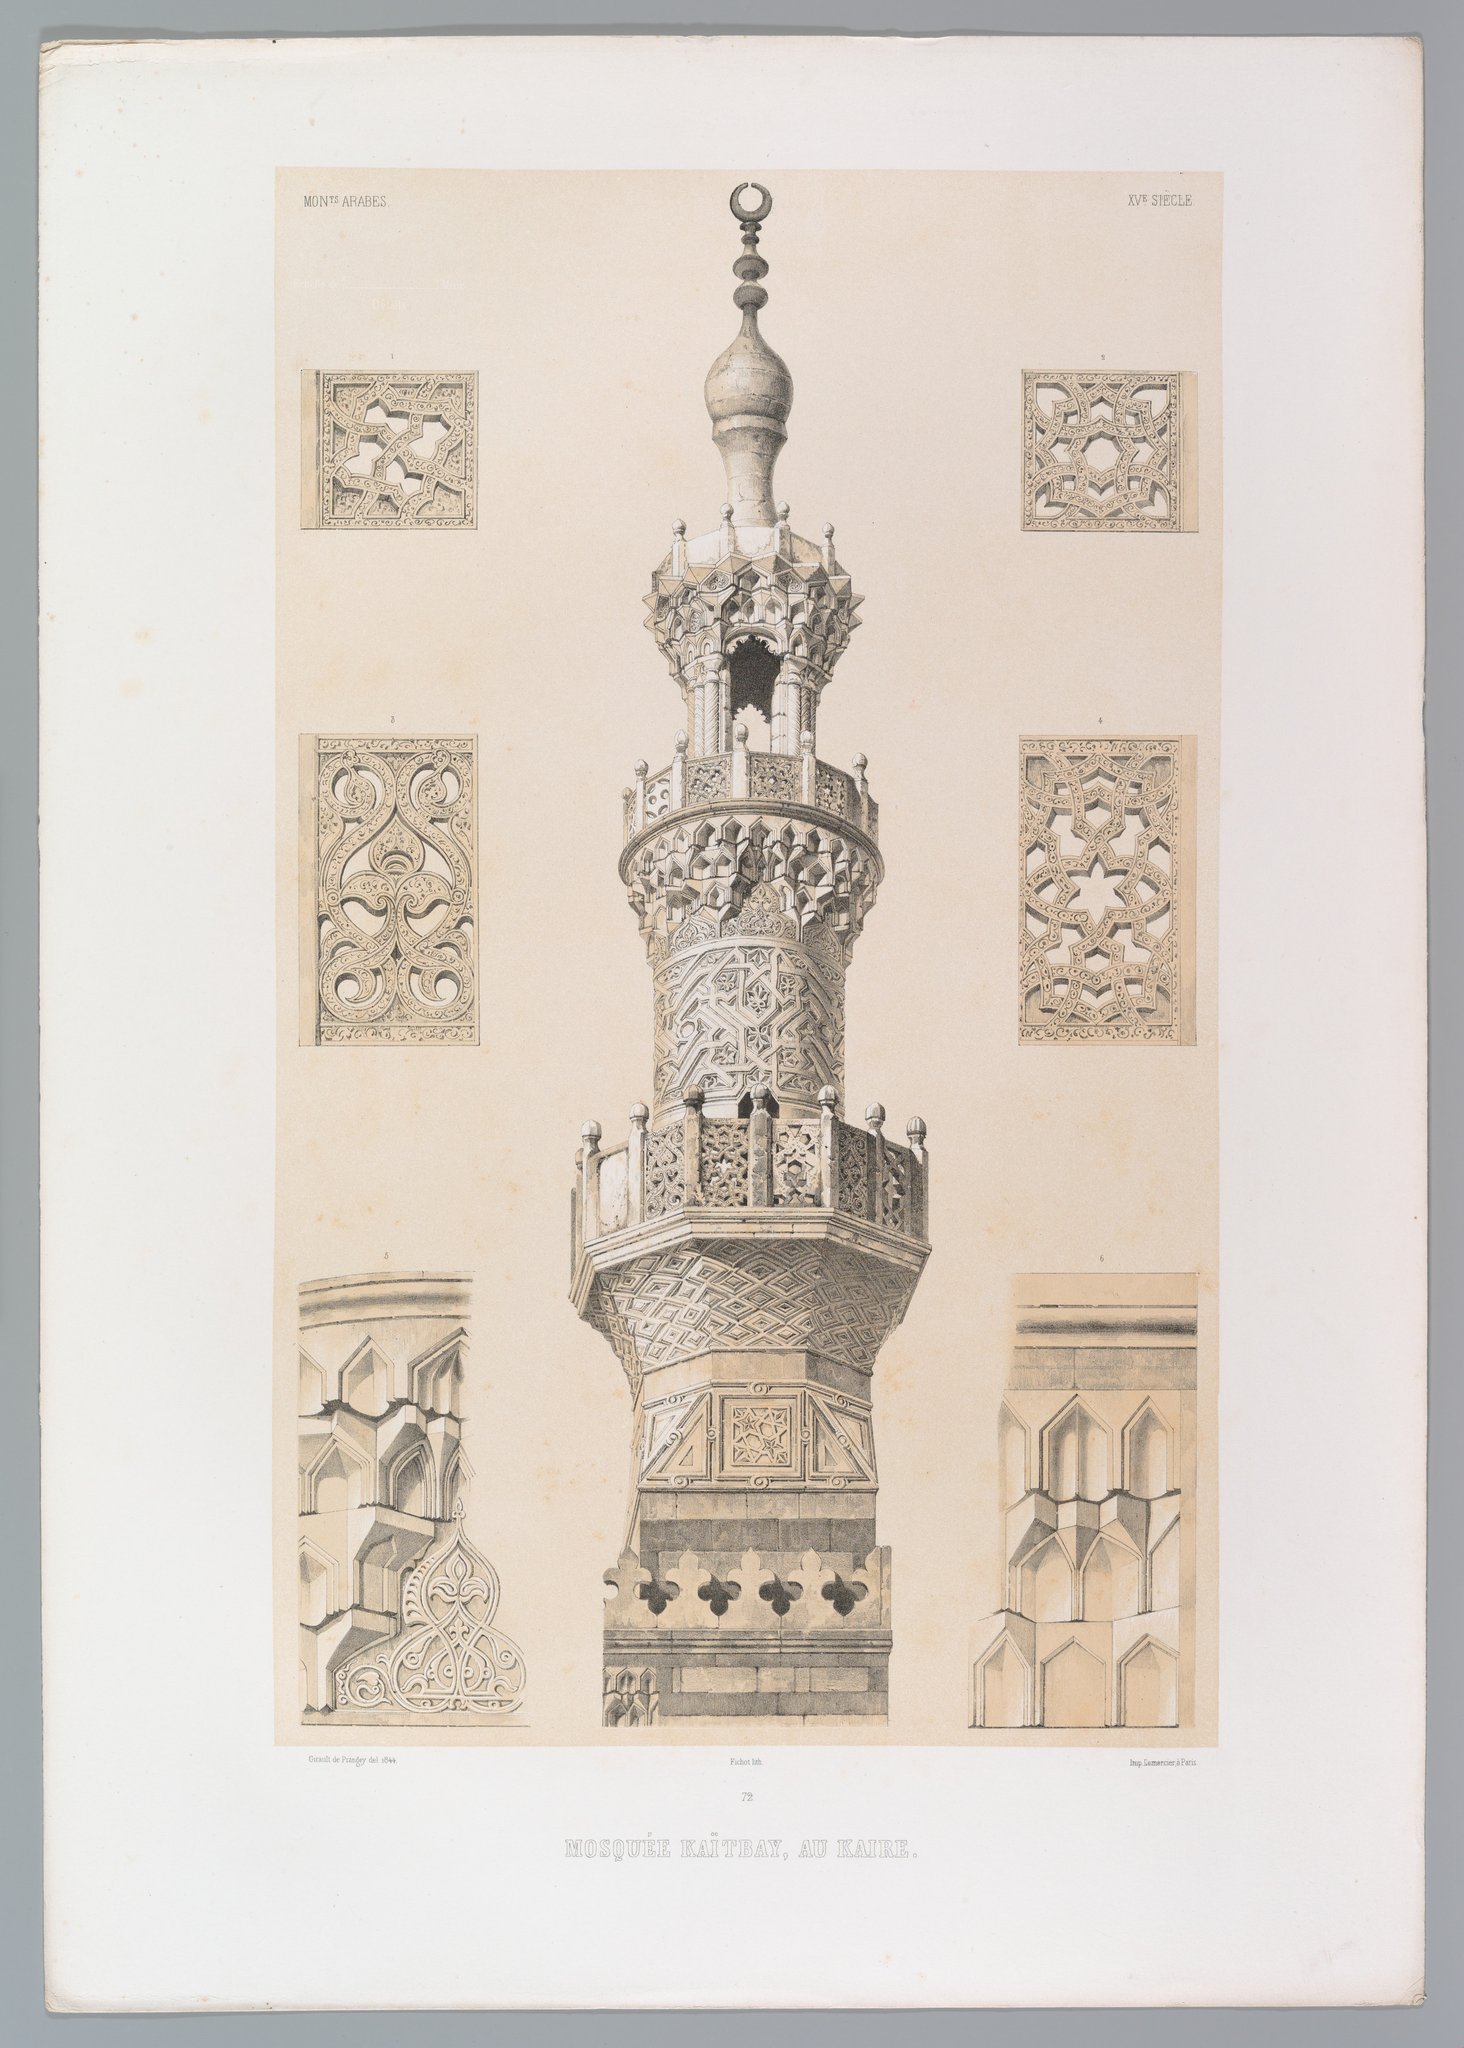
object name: lithograph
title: 72. Minaret, Mosquée Kaïtbay, au Kaire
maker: joseph-philibert girault de prangey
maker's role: artist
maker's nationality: french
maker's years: 1804-1892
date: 1843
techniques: lithograph